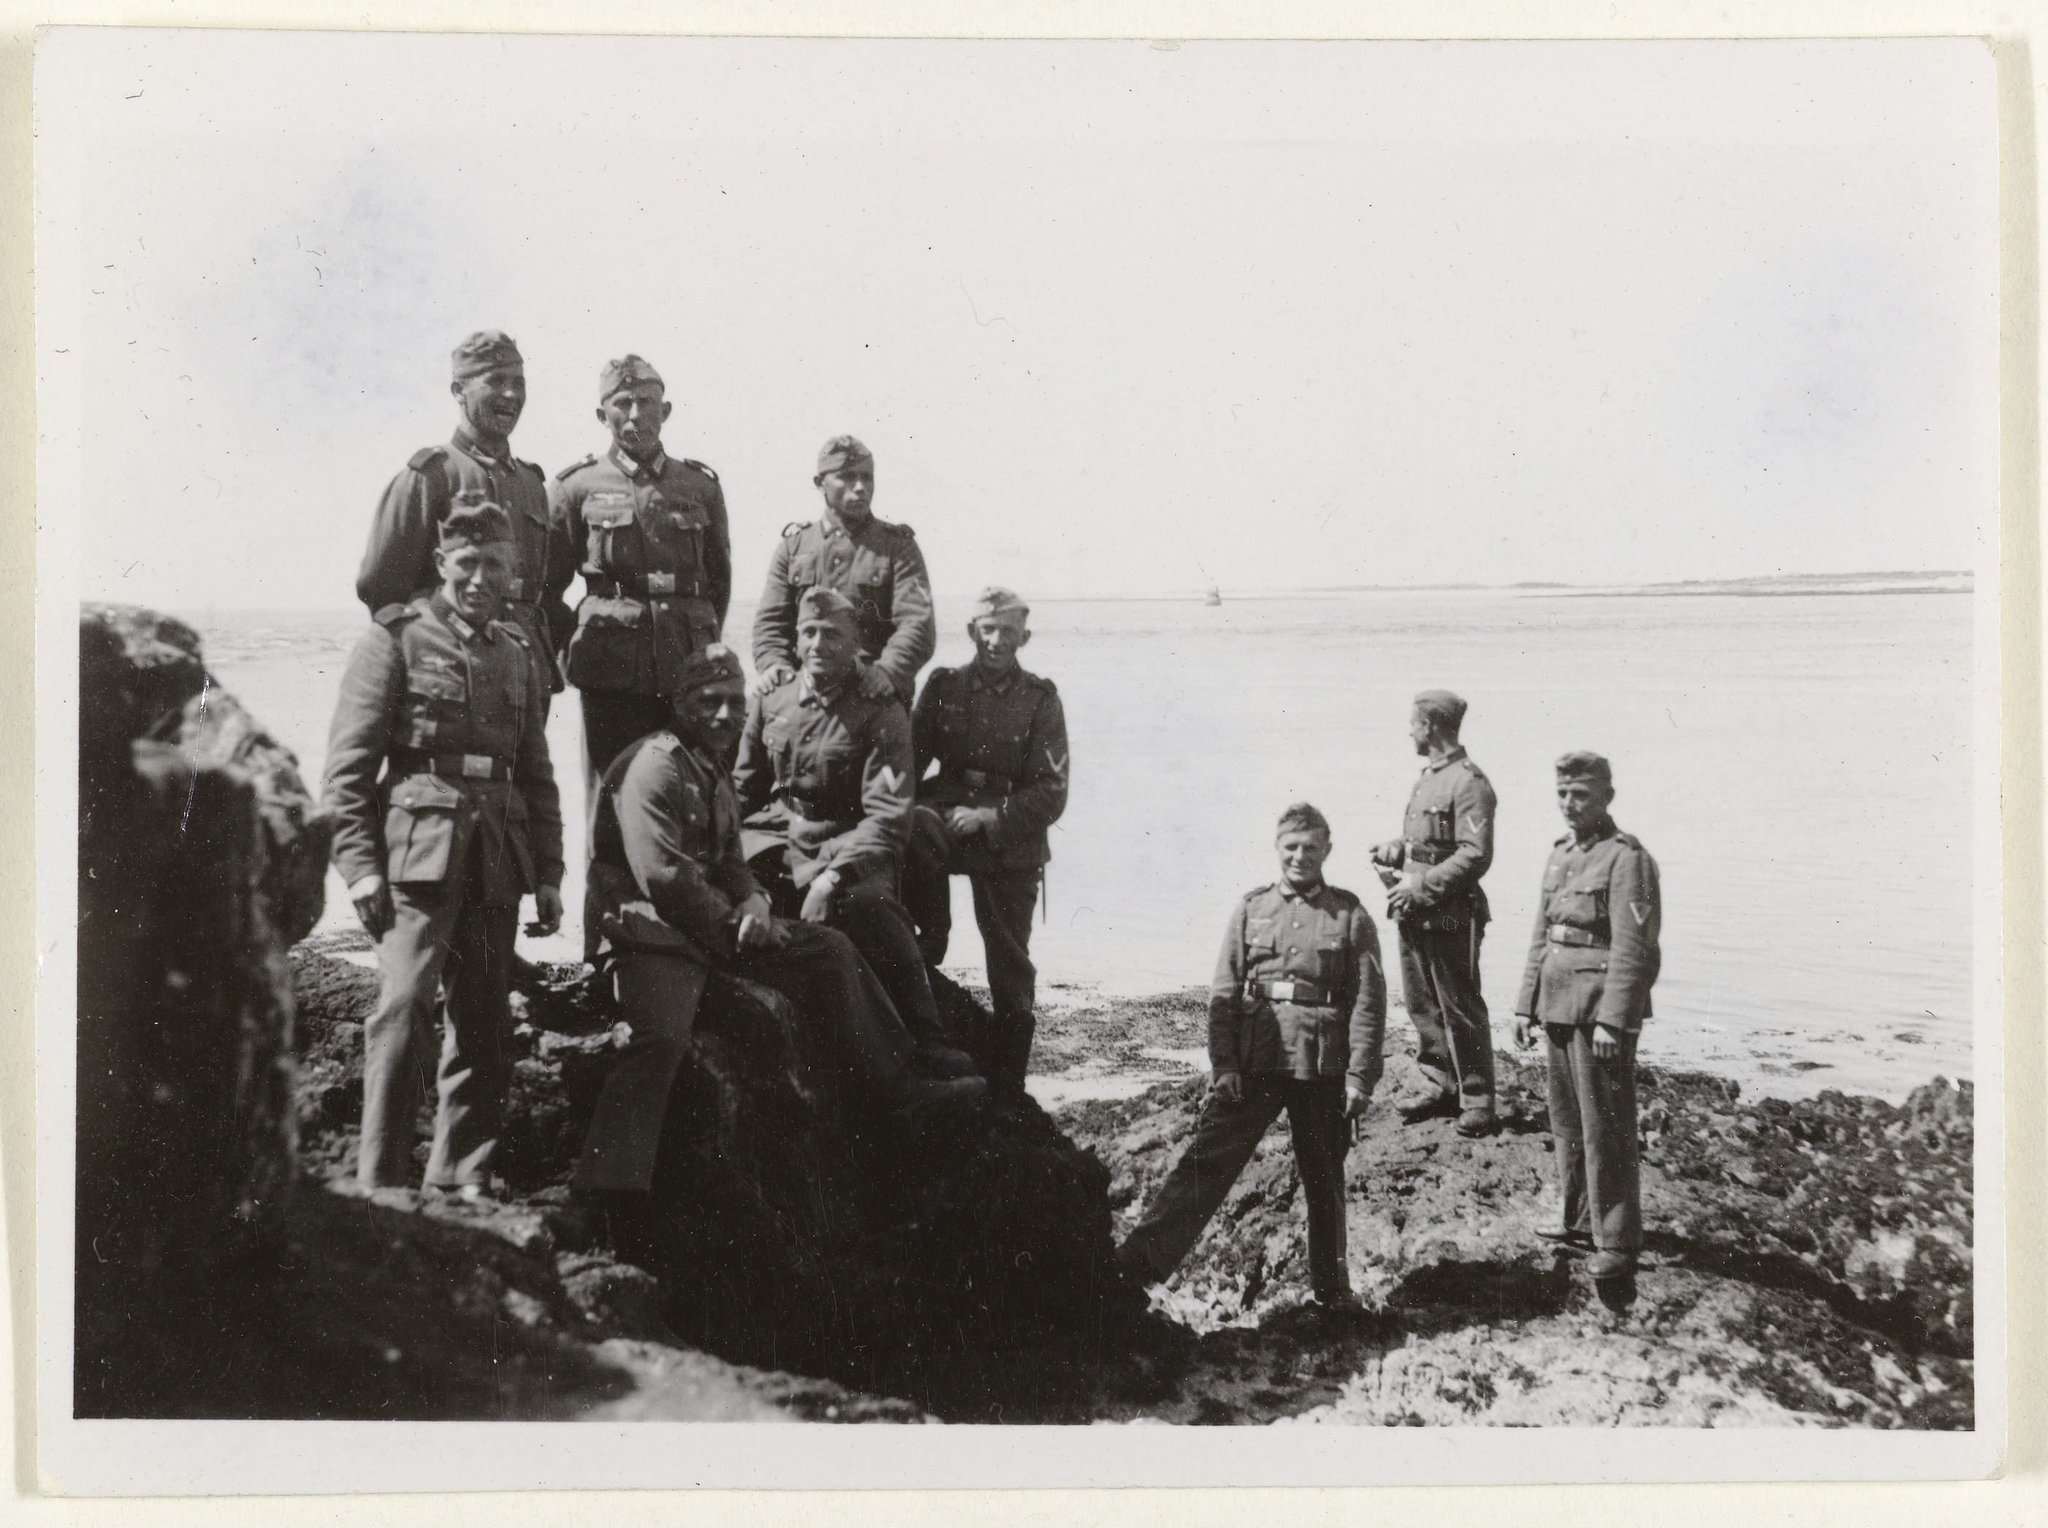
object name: photograph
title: Duitse soldaten op een rotsige kust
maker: Anonymous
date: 1941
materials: photographic support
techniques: photography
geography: france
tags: the company, the unit, the troop ~ military service, france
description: Amateurfoto van Duitse soldaten uit 1941. Ze staan in uniform op de rotsen voor de zee.